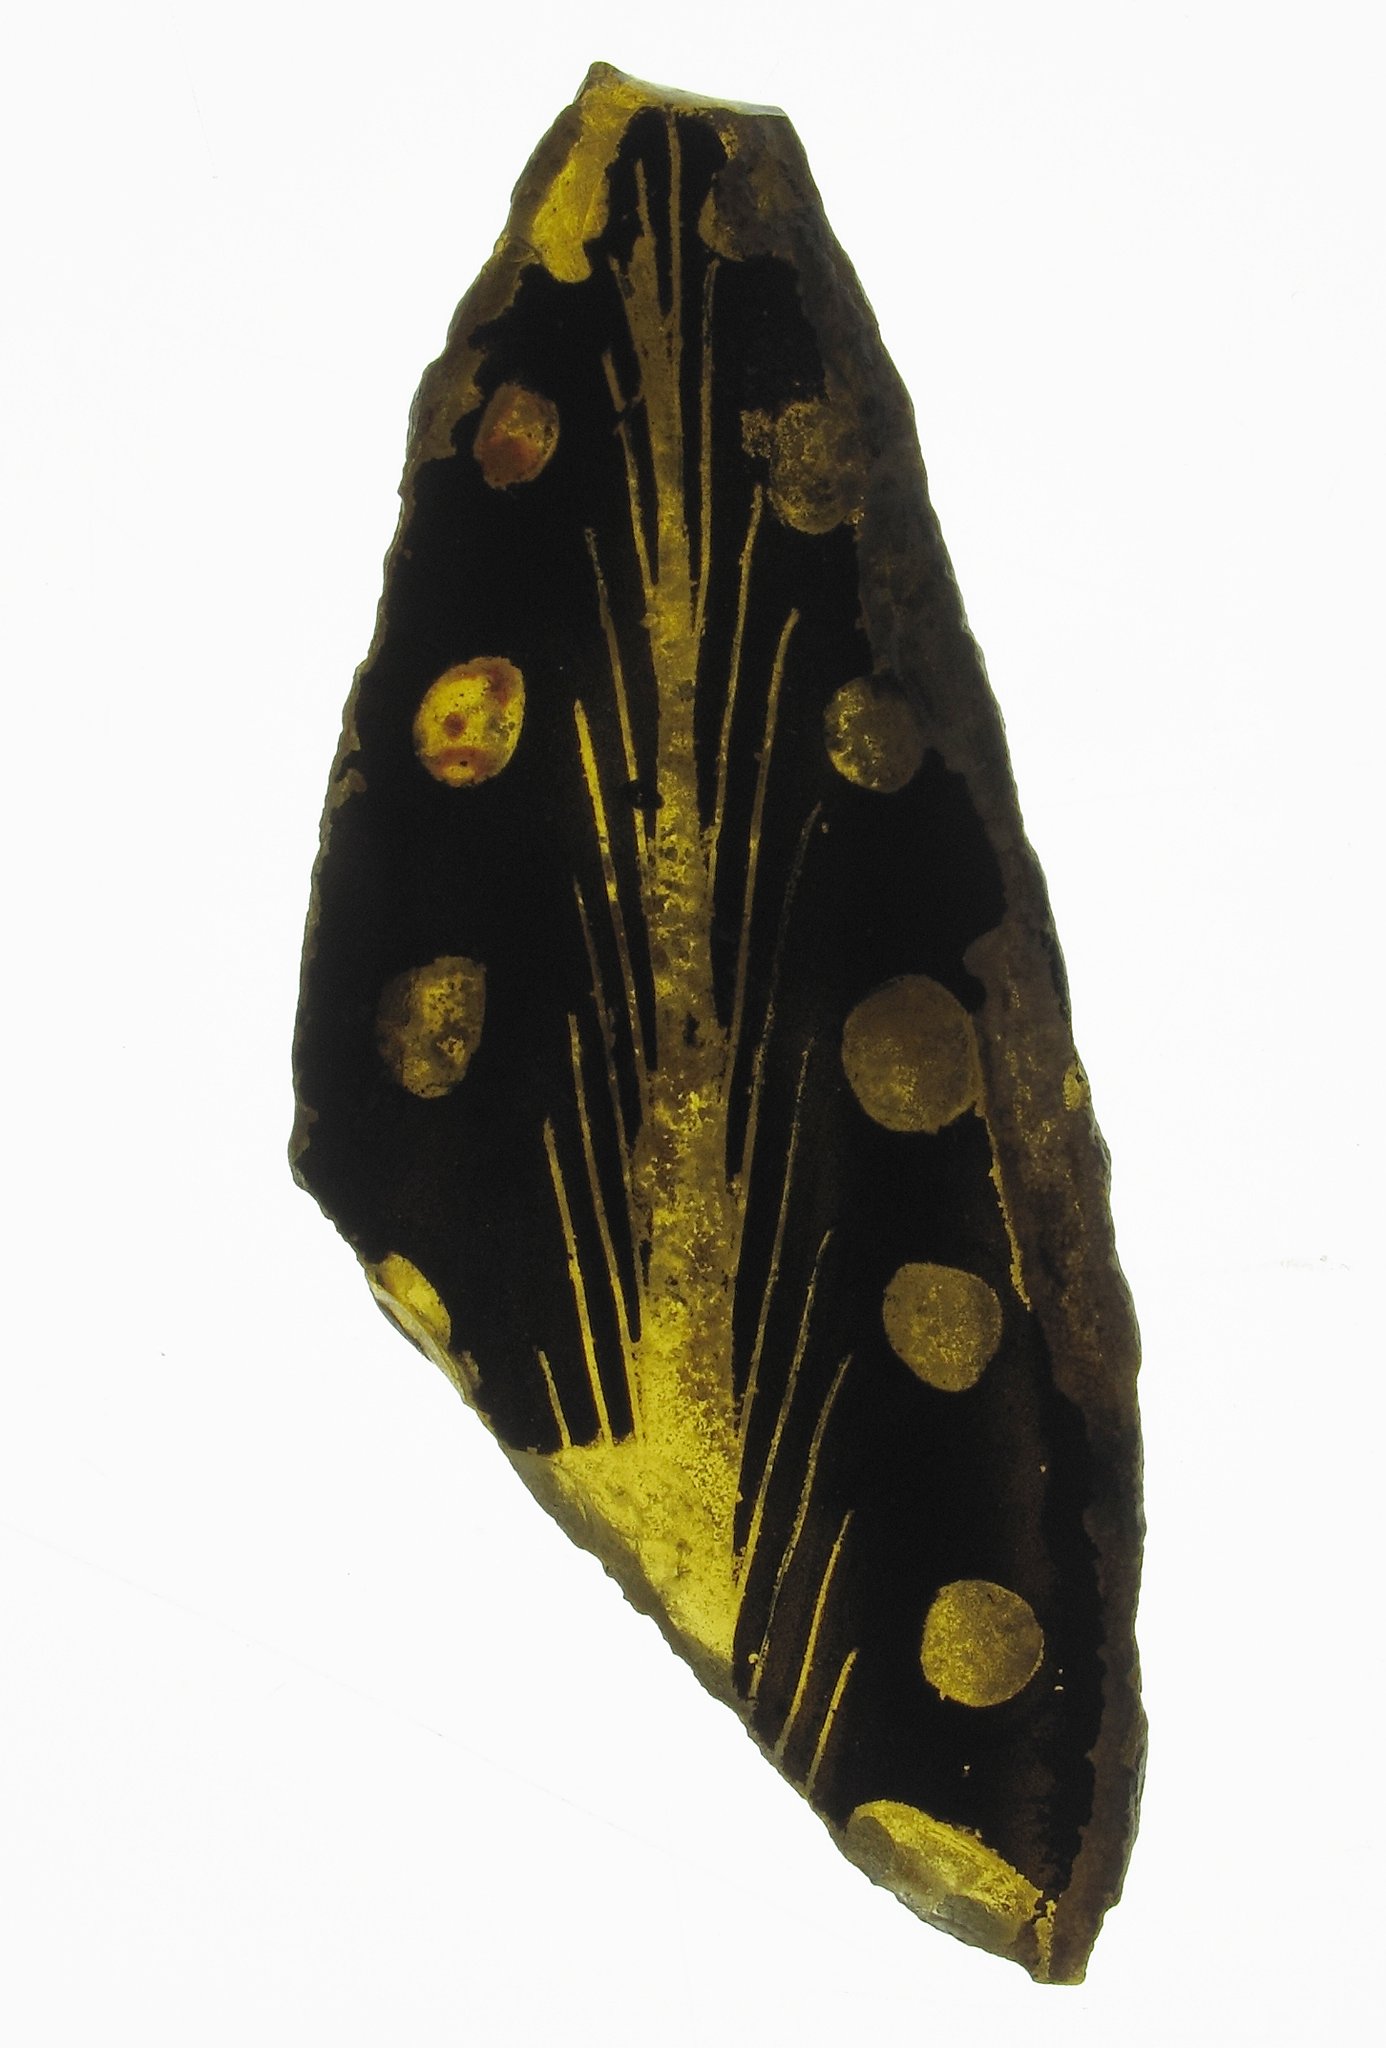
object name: fragment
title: Glass Fragment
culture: european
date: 1401-1500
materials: glass, metal